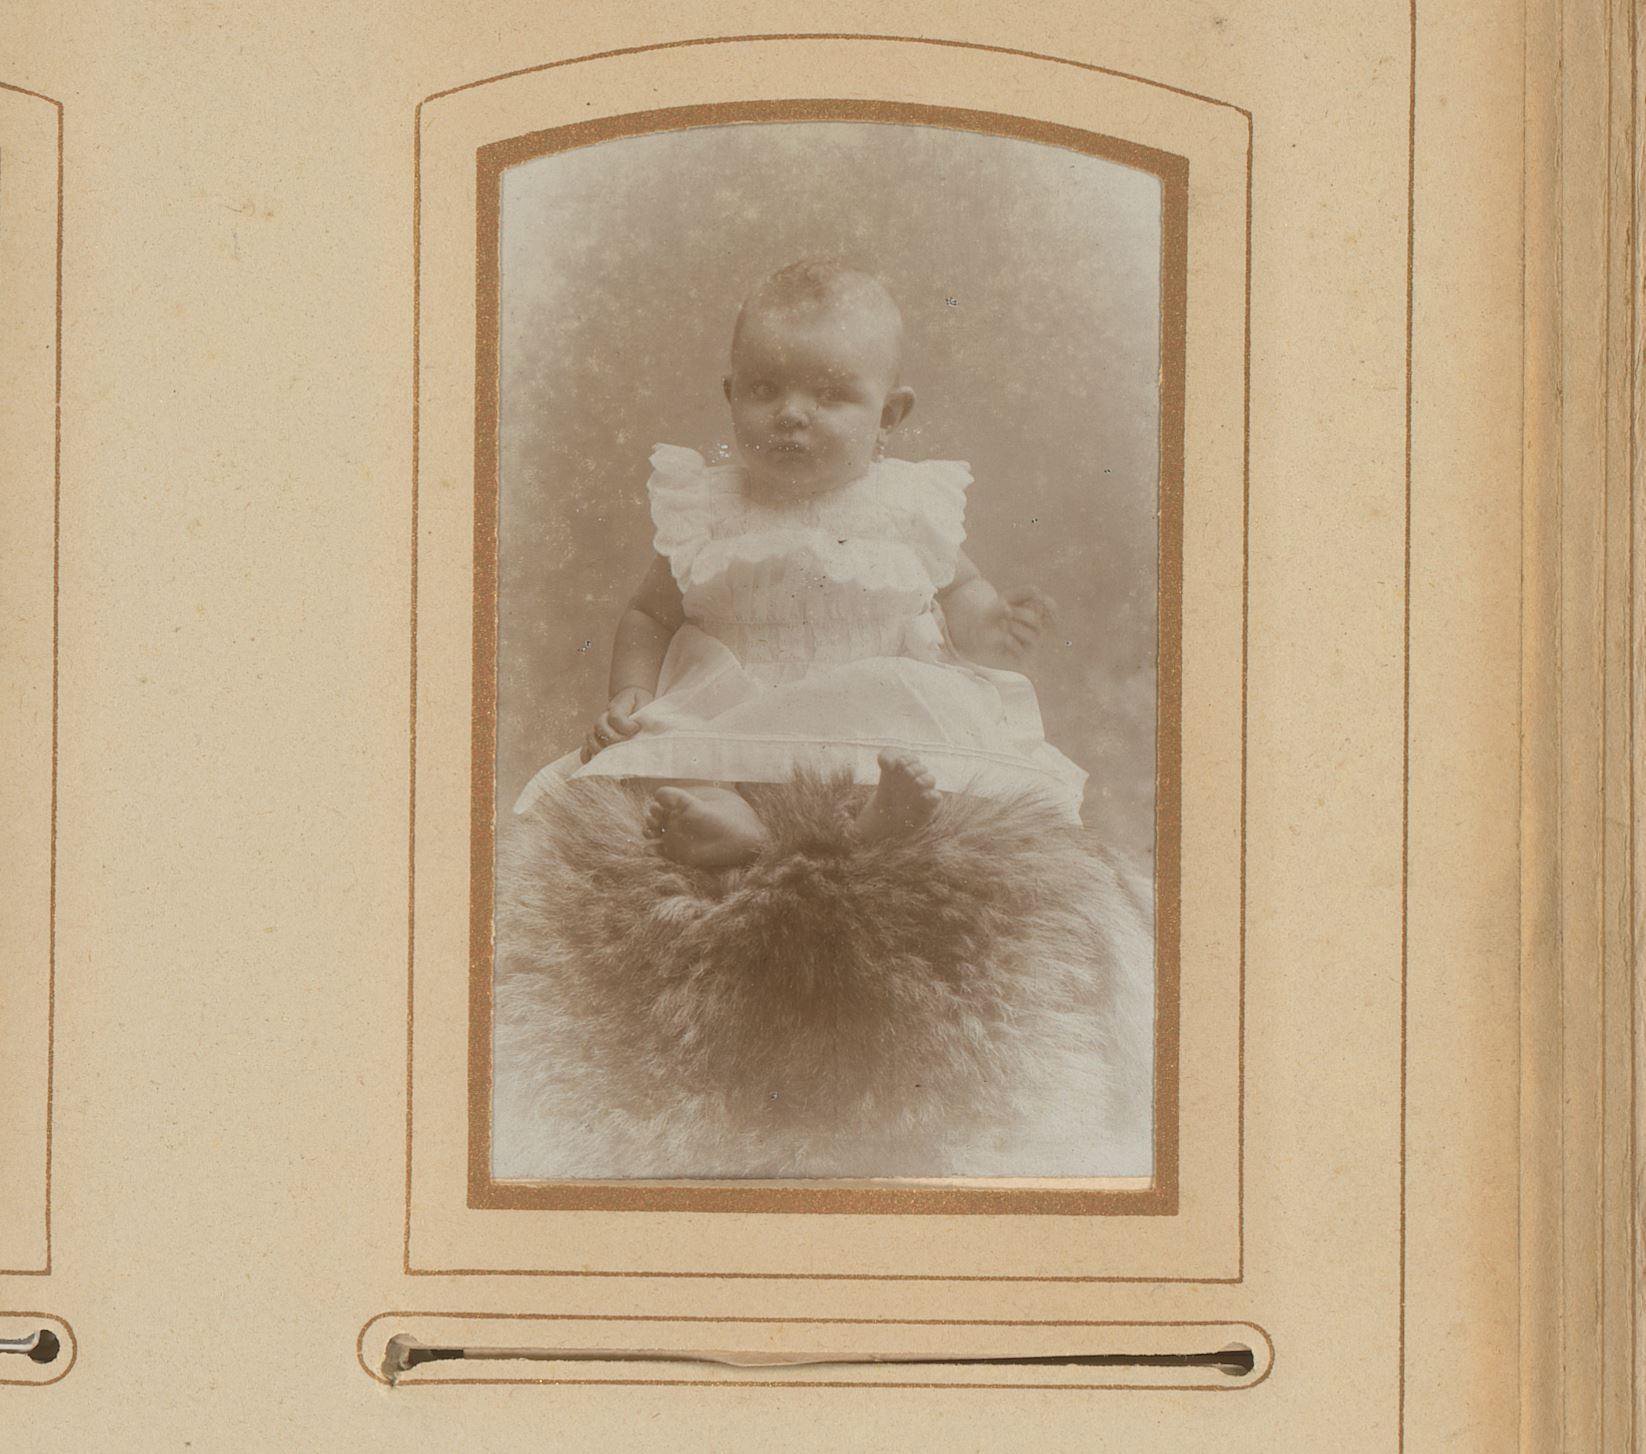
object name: photograph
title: Portret van een zittend meisje in witte jurk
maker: jan van roon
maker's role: fotograaf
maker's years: 1879-1948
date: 1903-1940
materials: cardboard, photographic support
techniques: collodion silver print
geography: haarlem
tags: infant, baby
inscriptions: inscription: ‘Atelier van Roon/ Gen. Cronjéstraat 41 en 43/ Haarlem’